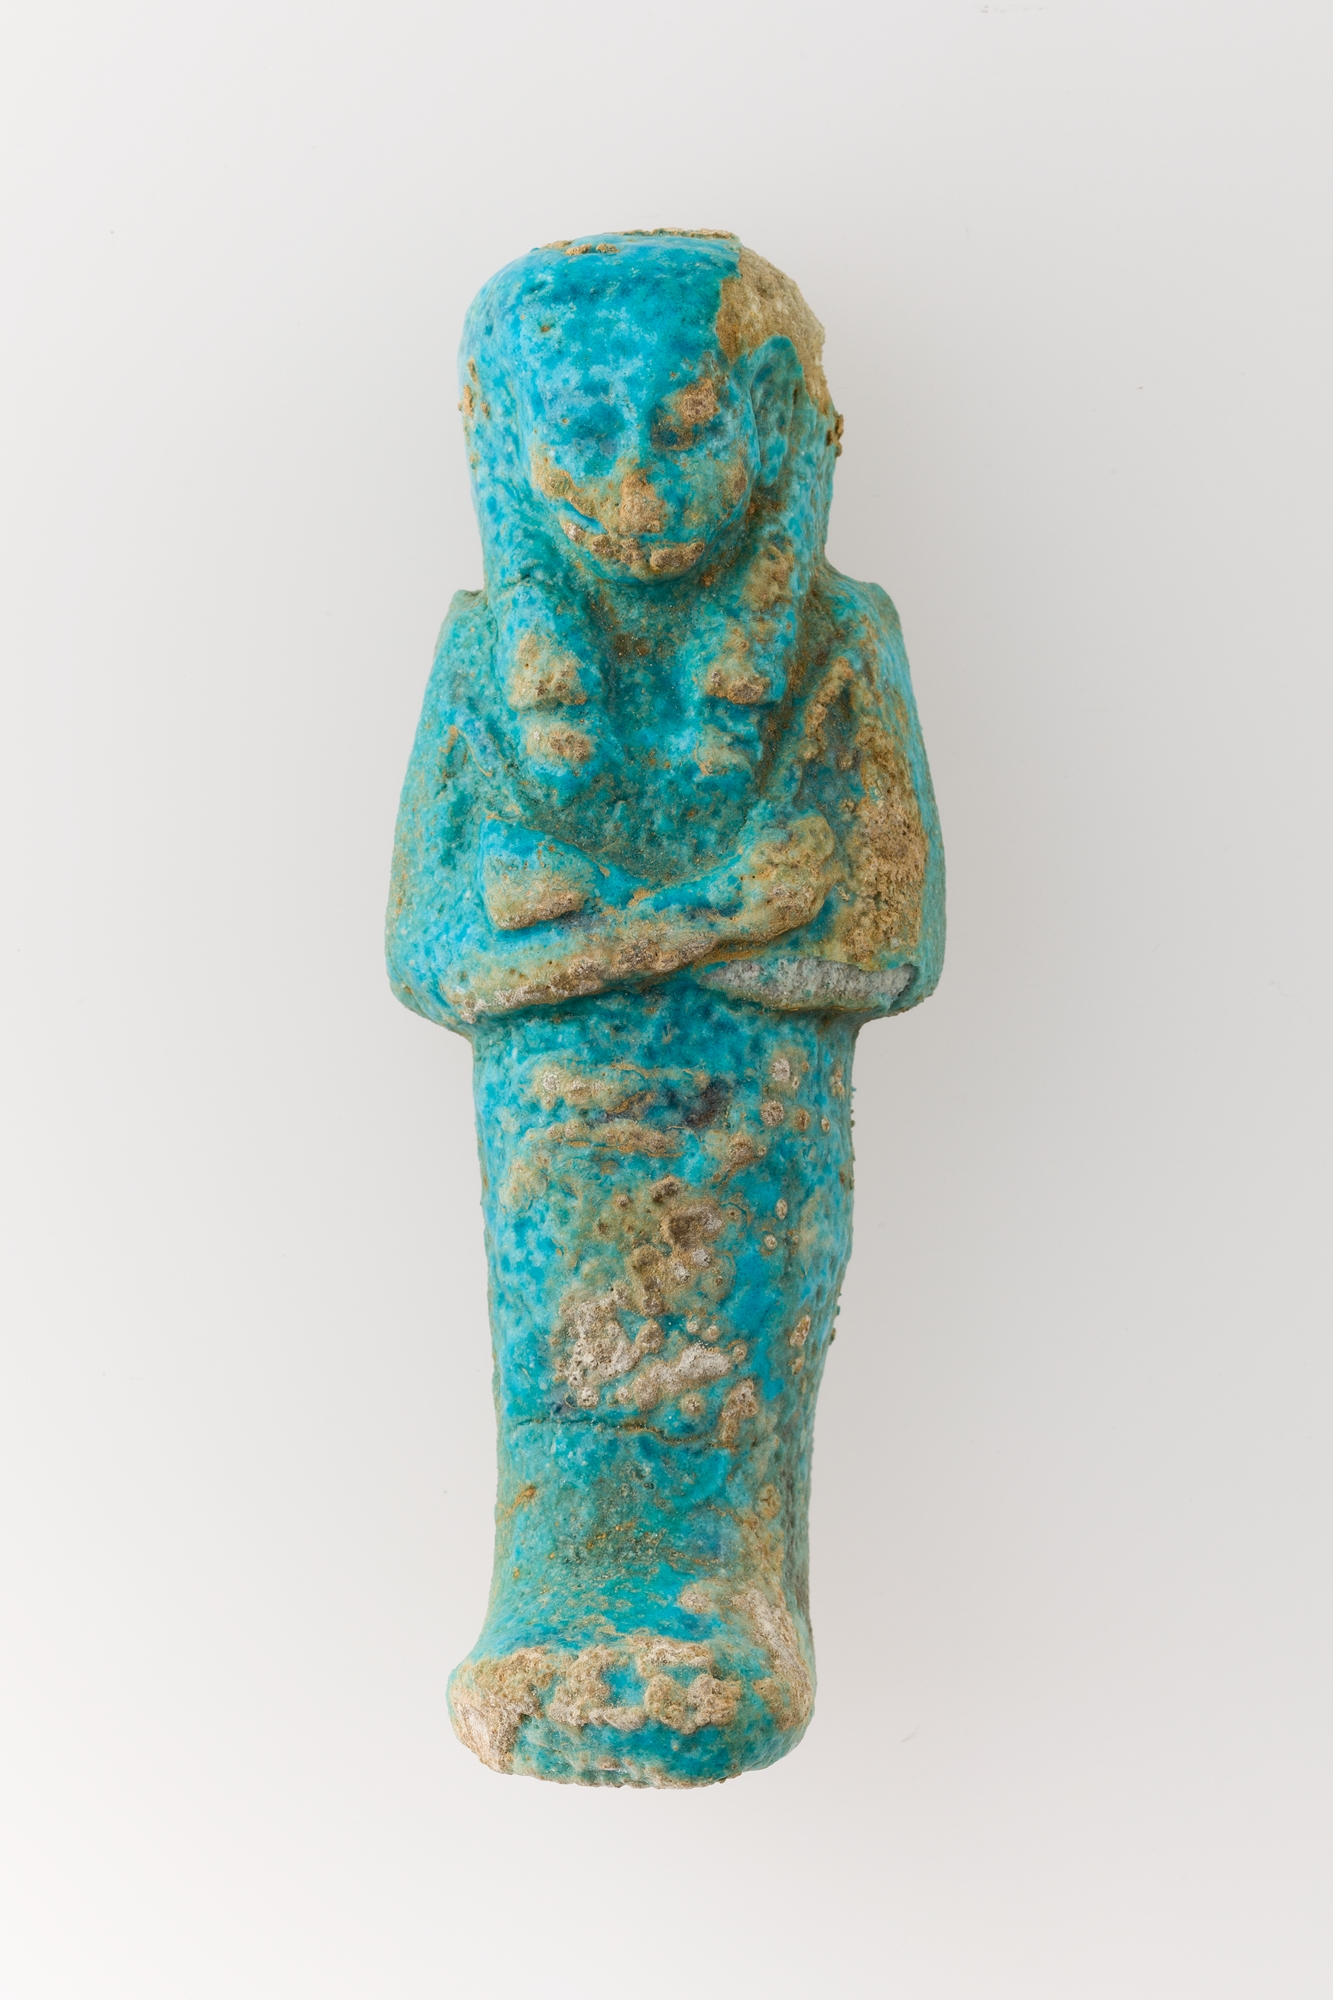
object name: shabti, henettawy c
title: Worker Shabti of Henettawy (C), Daughter of Isetemkheb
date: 990-970 BCE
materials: faience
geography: egypt